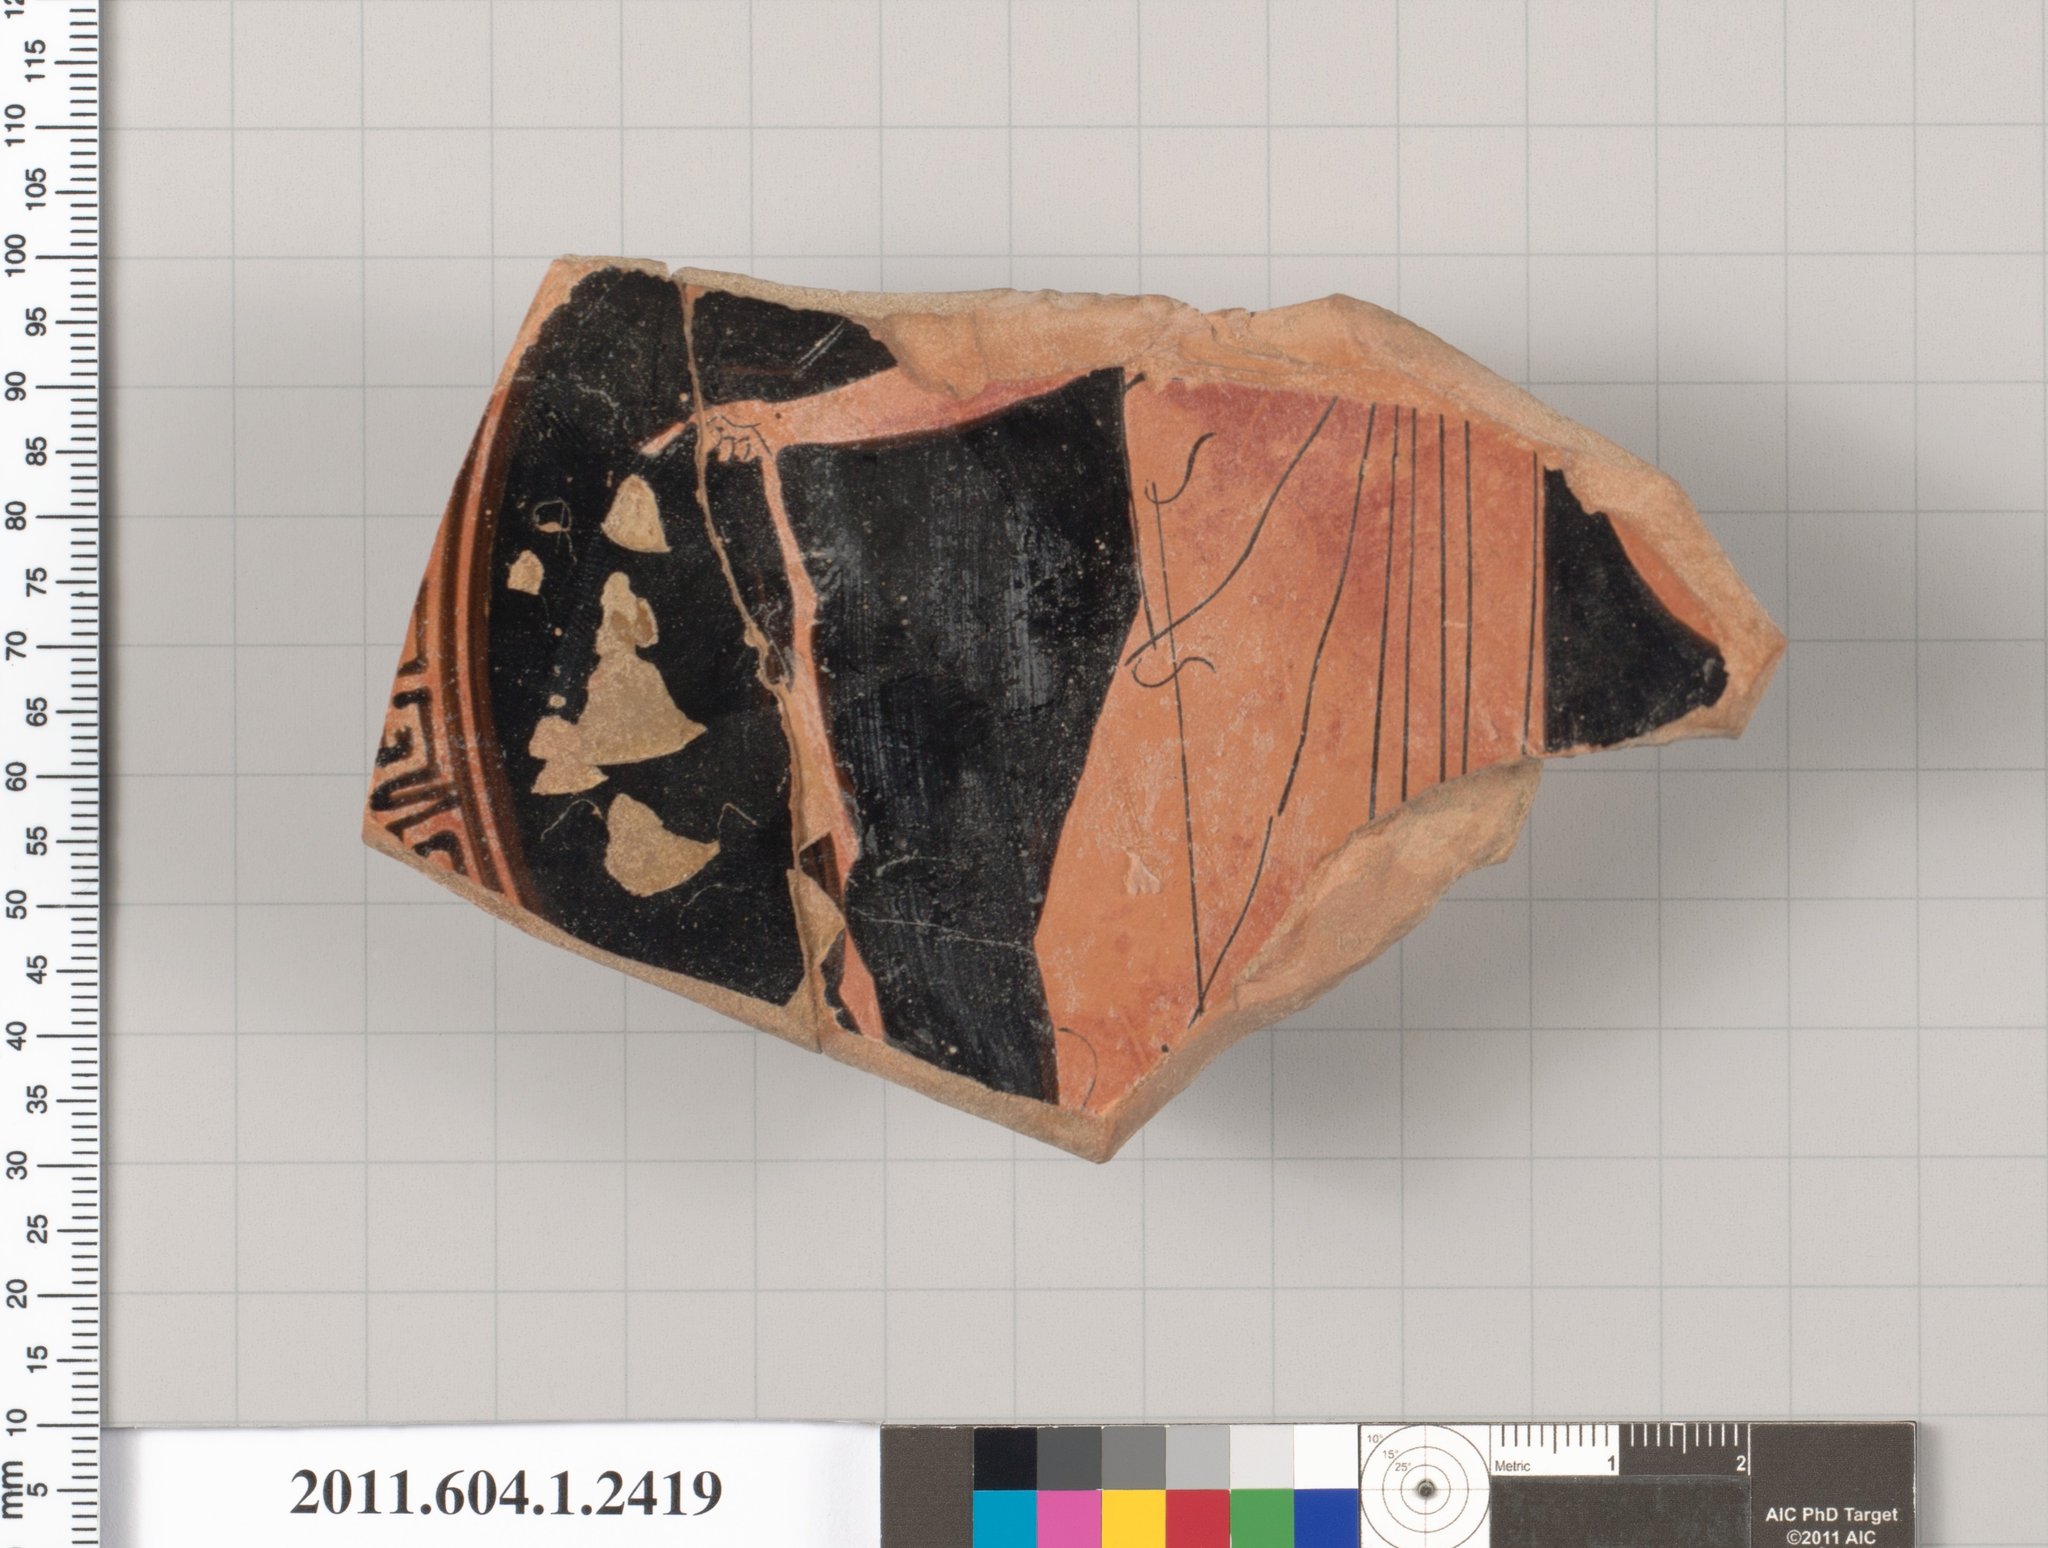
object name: kylix fragment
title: Terracotta fragment of a kylix (drinking cup)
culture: greek, attic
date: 475-451 BCE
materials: terracotta